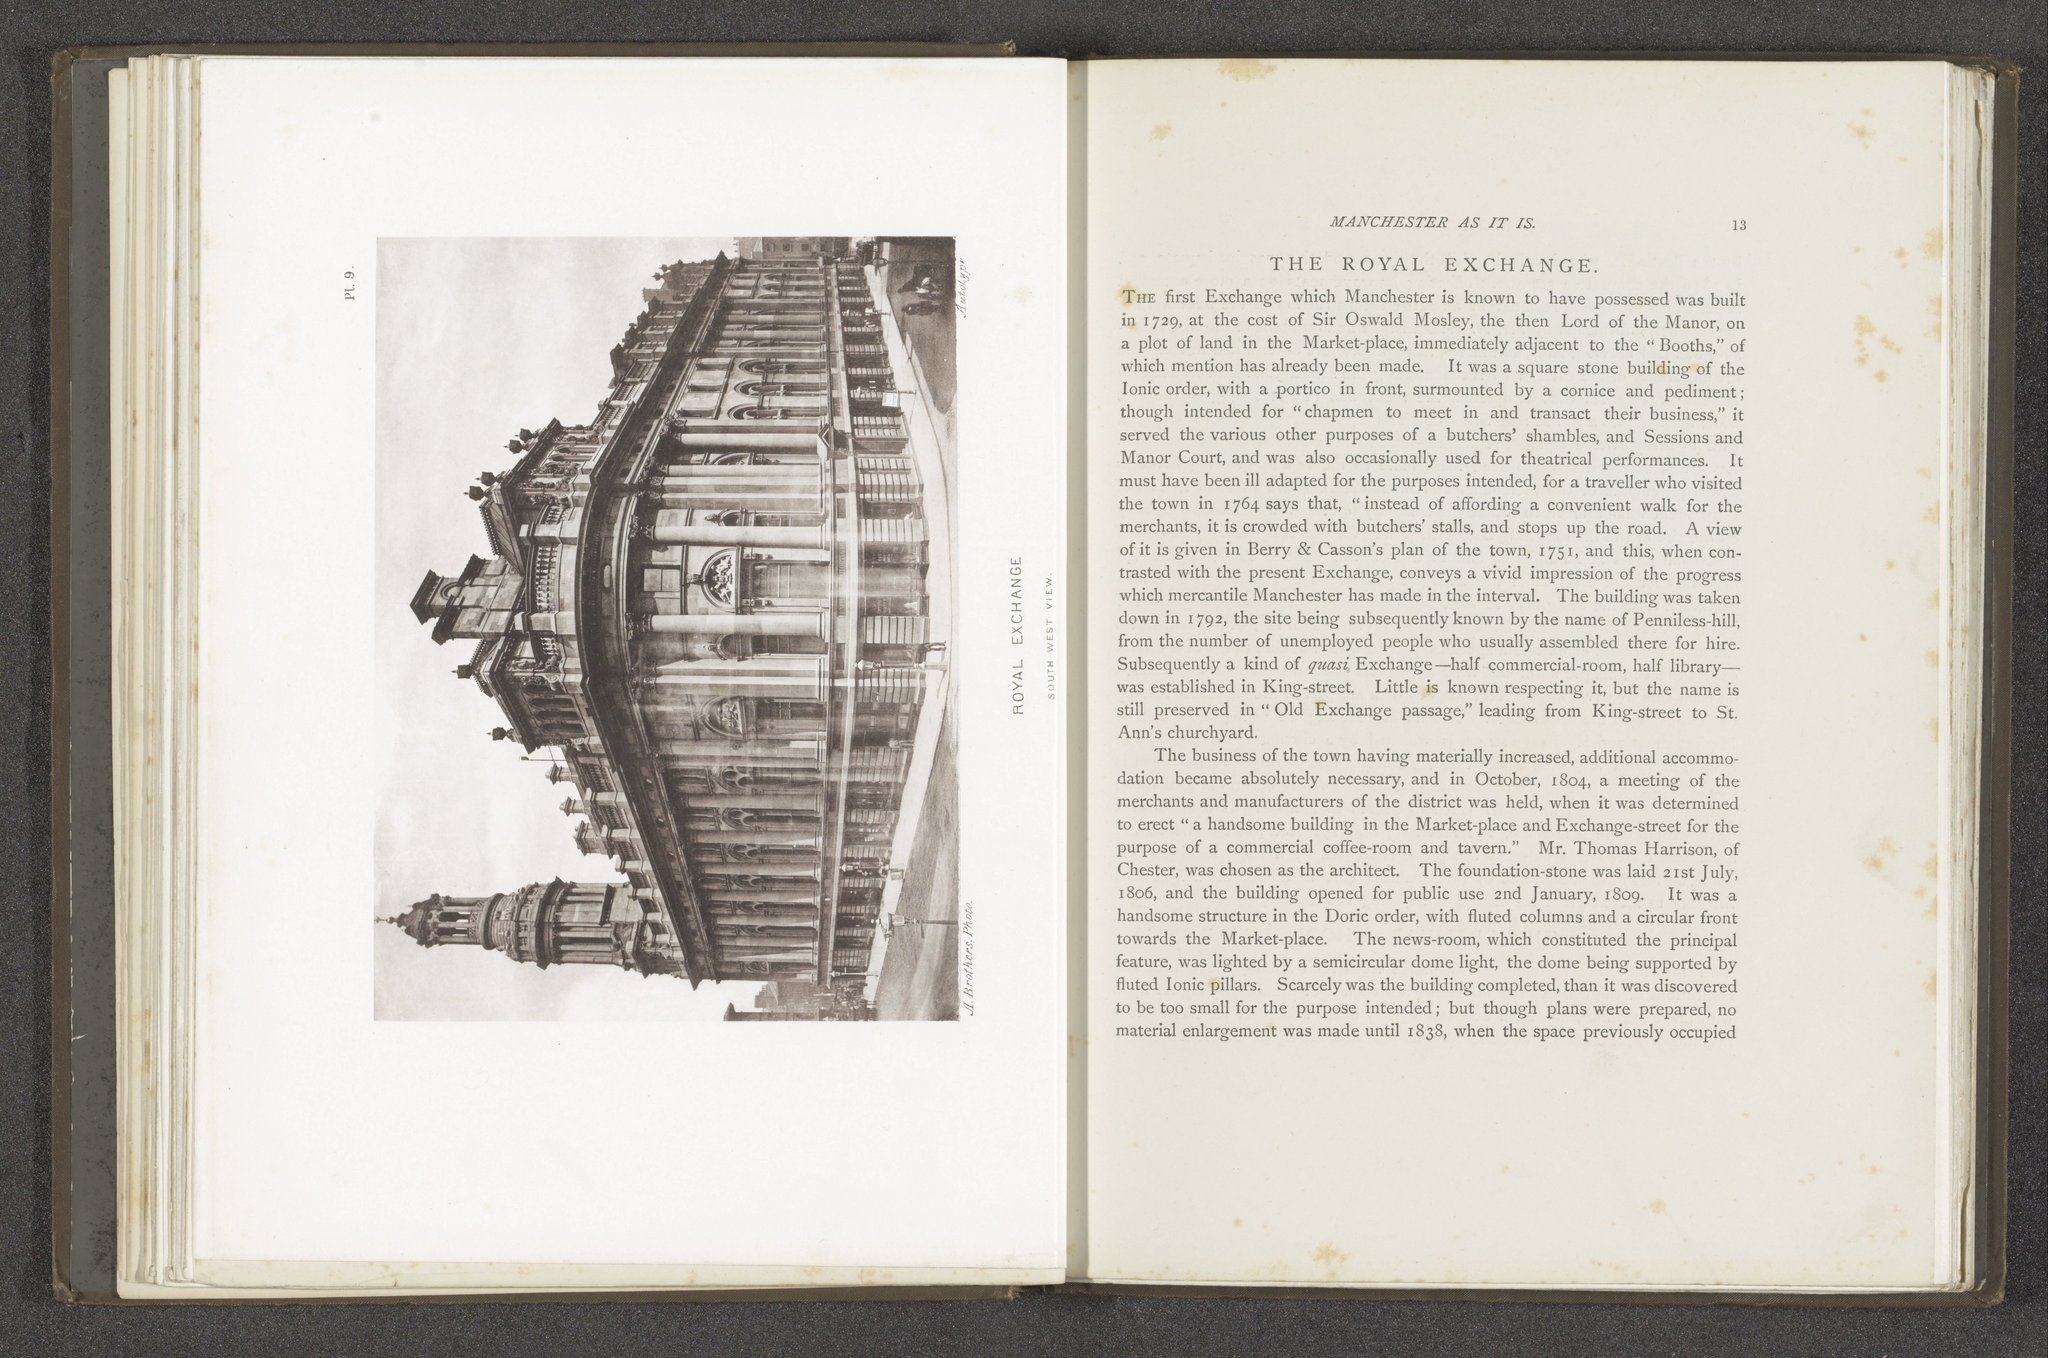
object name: page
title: Royal Exchange south west view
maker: Anonymous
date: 1868-1878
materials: paper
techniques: photograph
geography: manchester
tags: exchange, bourse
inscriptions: number: ‘Pl. 9.’